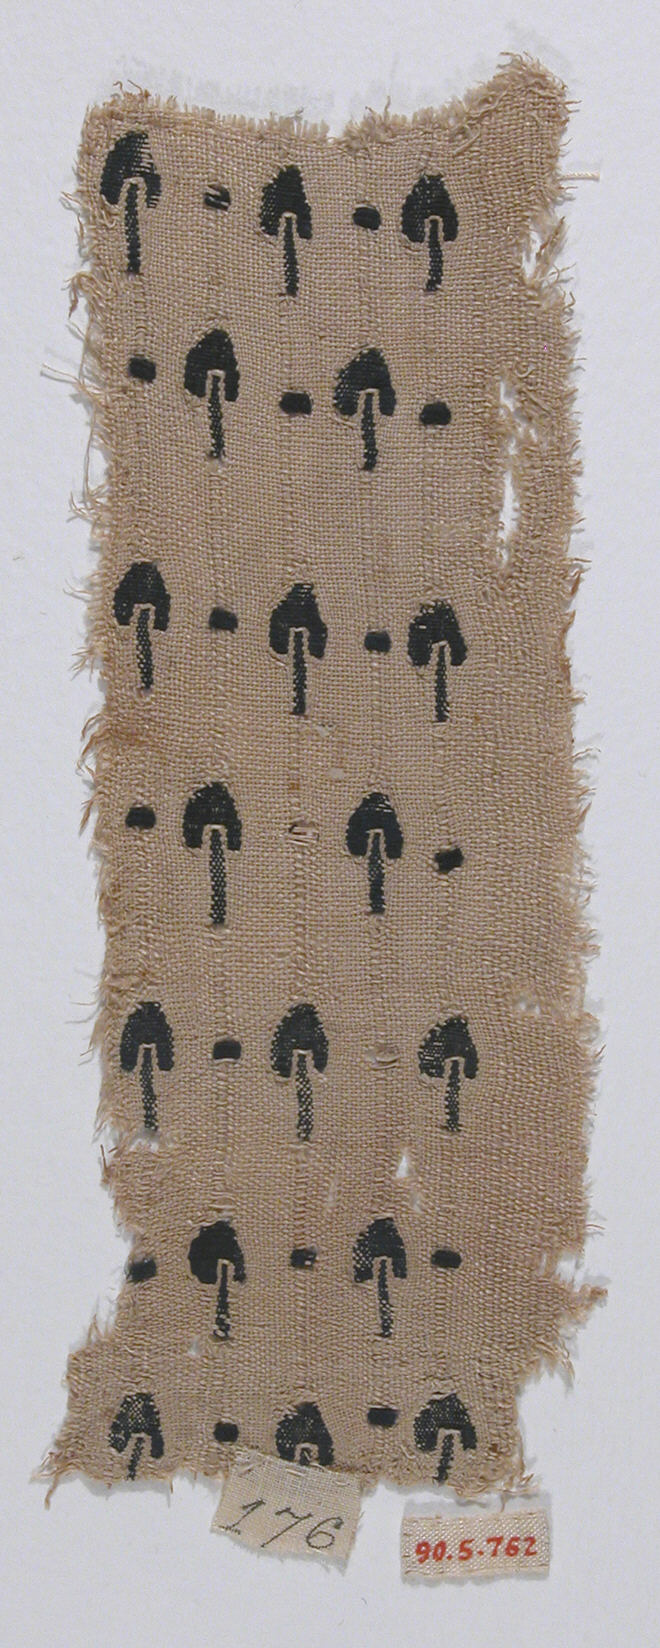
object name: textile fragment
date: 401-500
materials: linen, wool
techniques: weave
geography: egypt